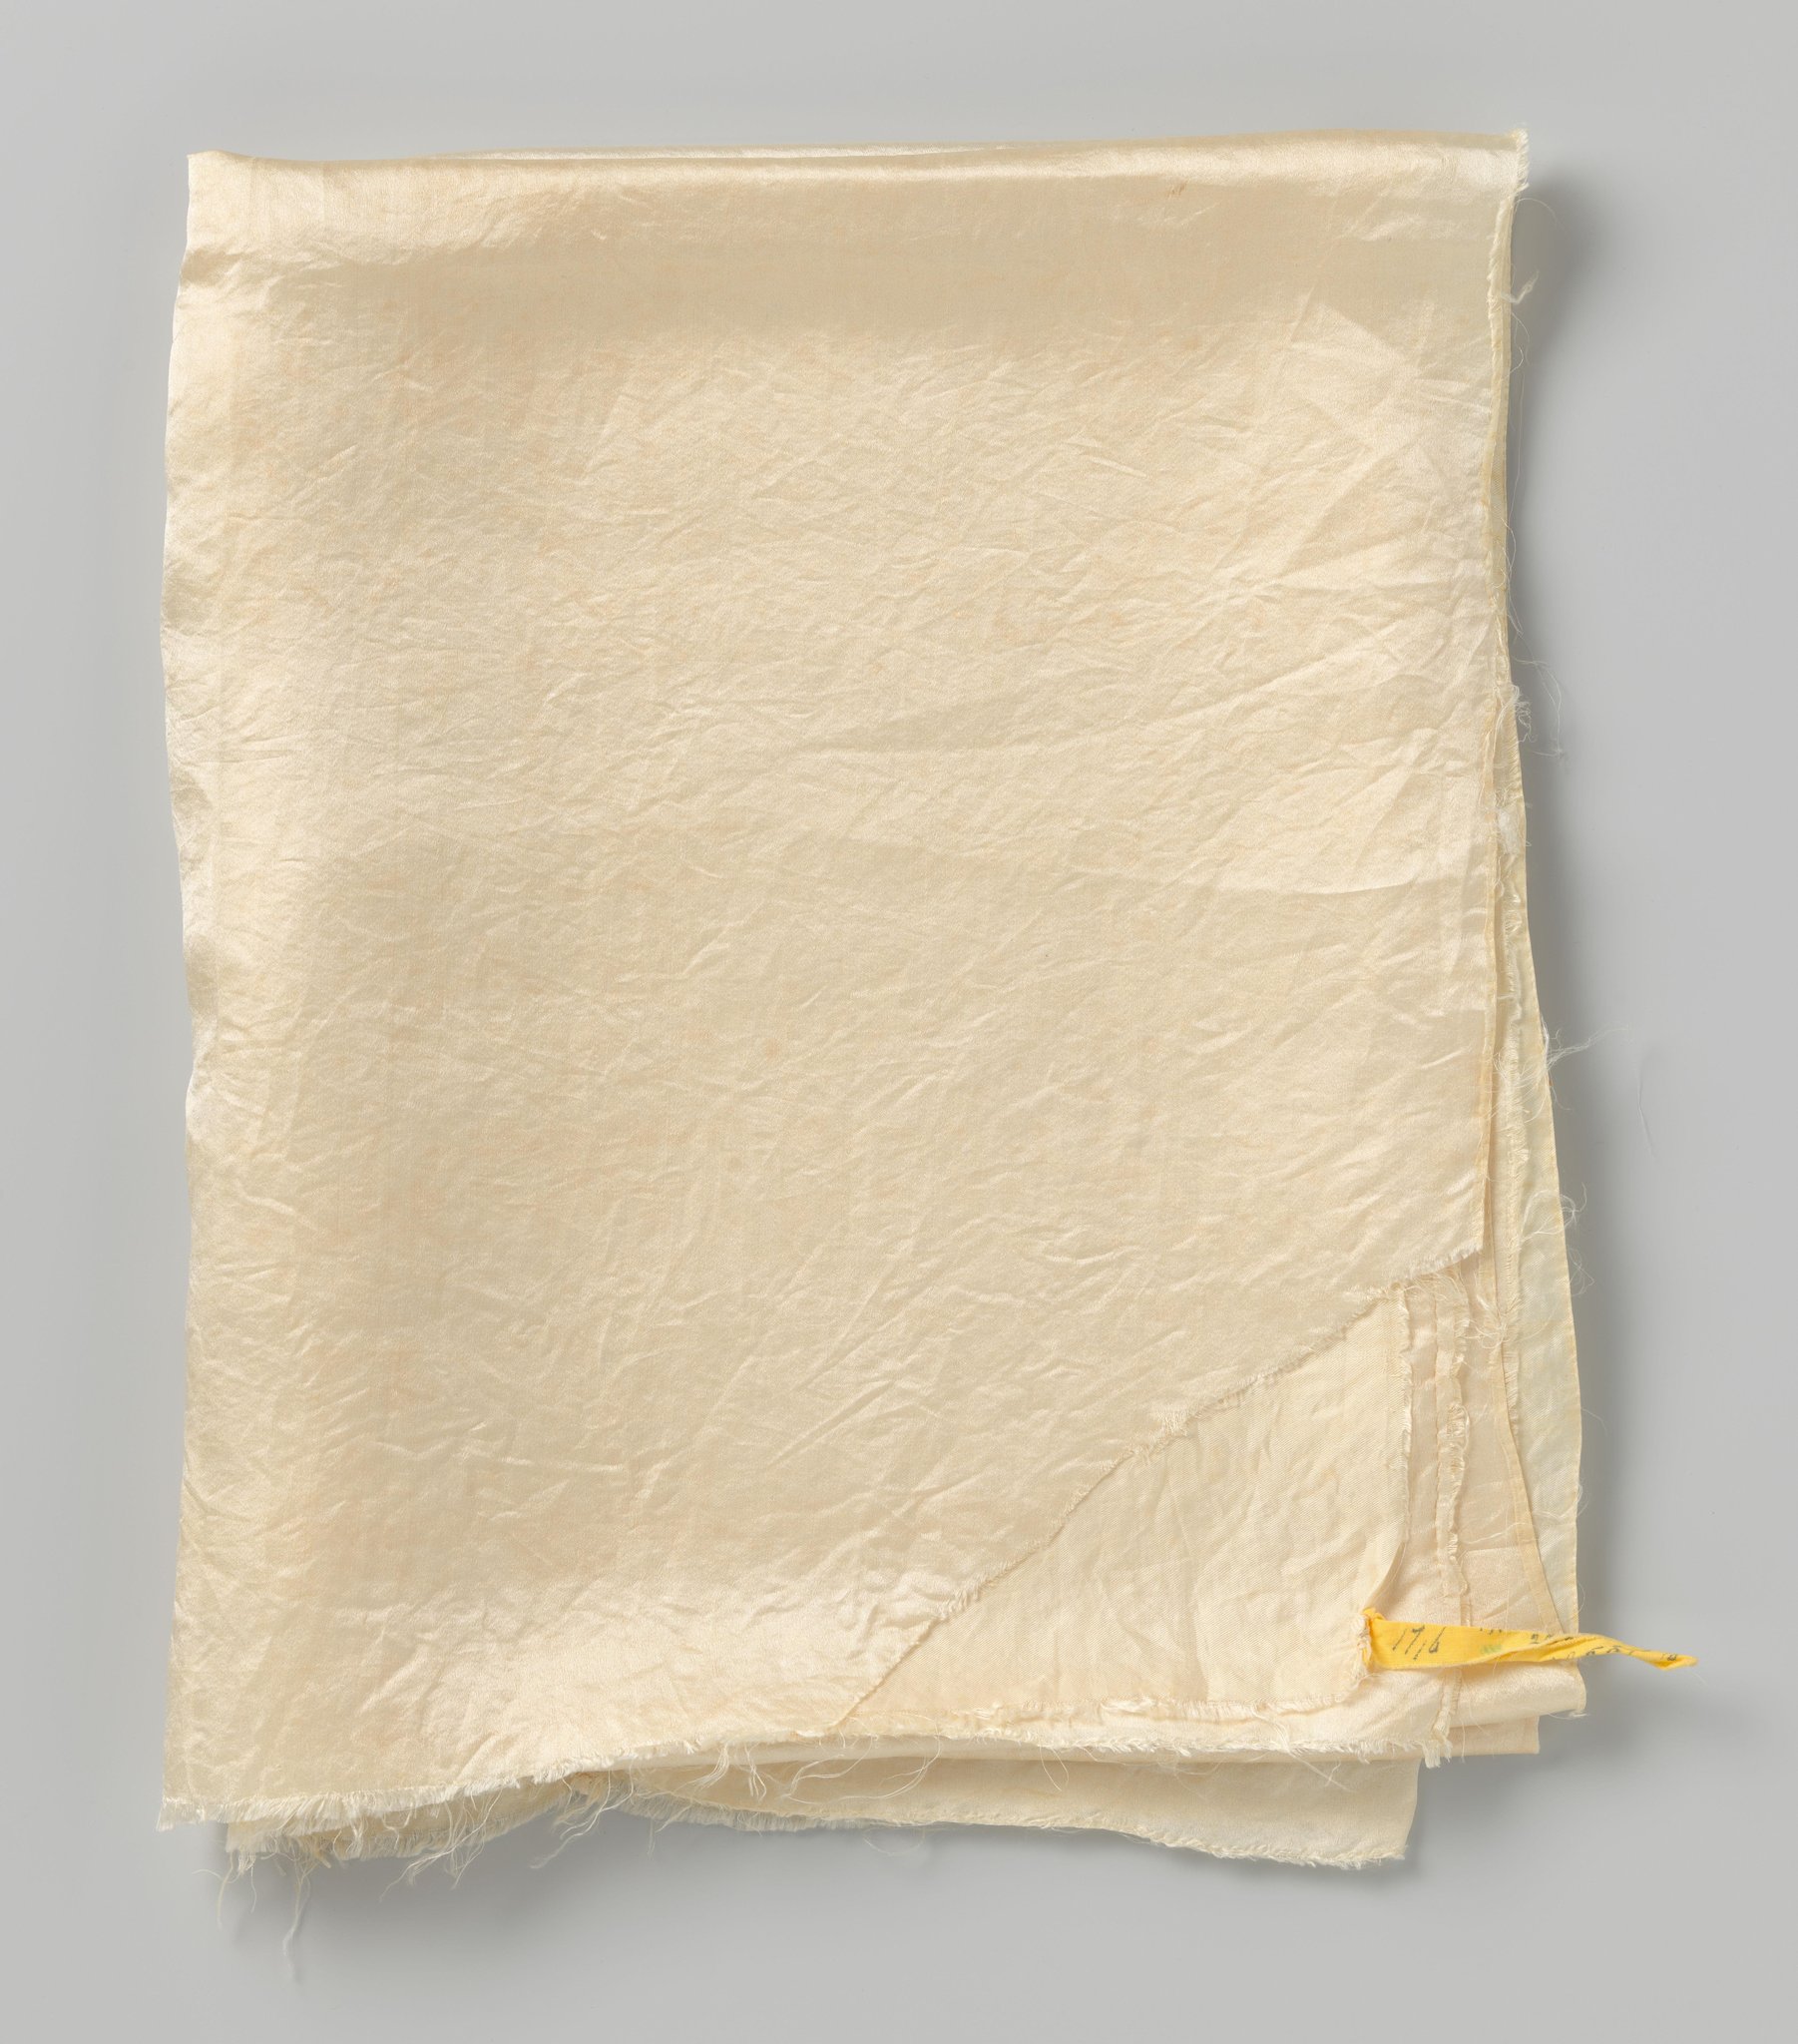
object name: liner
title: Voering van doopkleed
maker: Anonymous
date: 1850-1910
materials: textile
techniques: weave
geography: europe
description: Glanzend weefsel met geel label in een van de vier hoeken. Een van de hoeken is afgesneden.